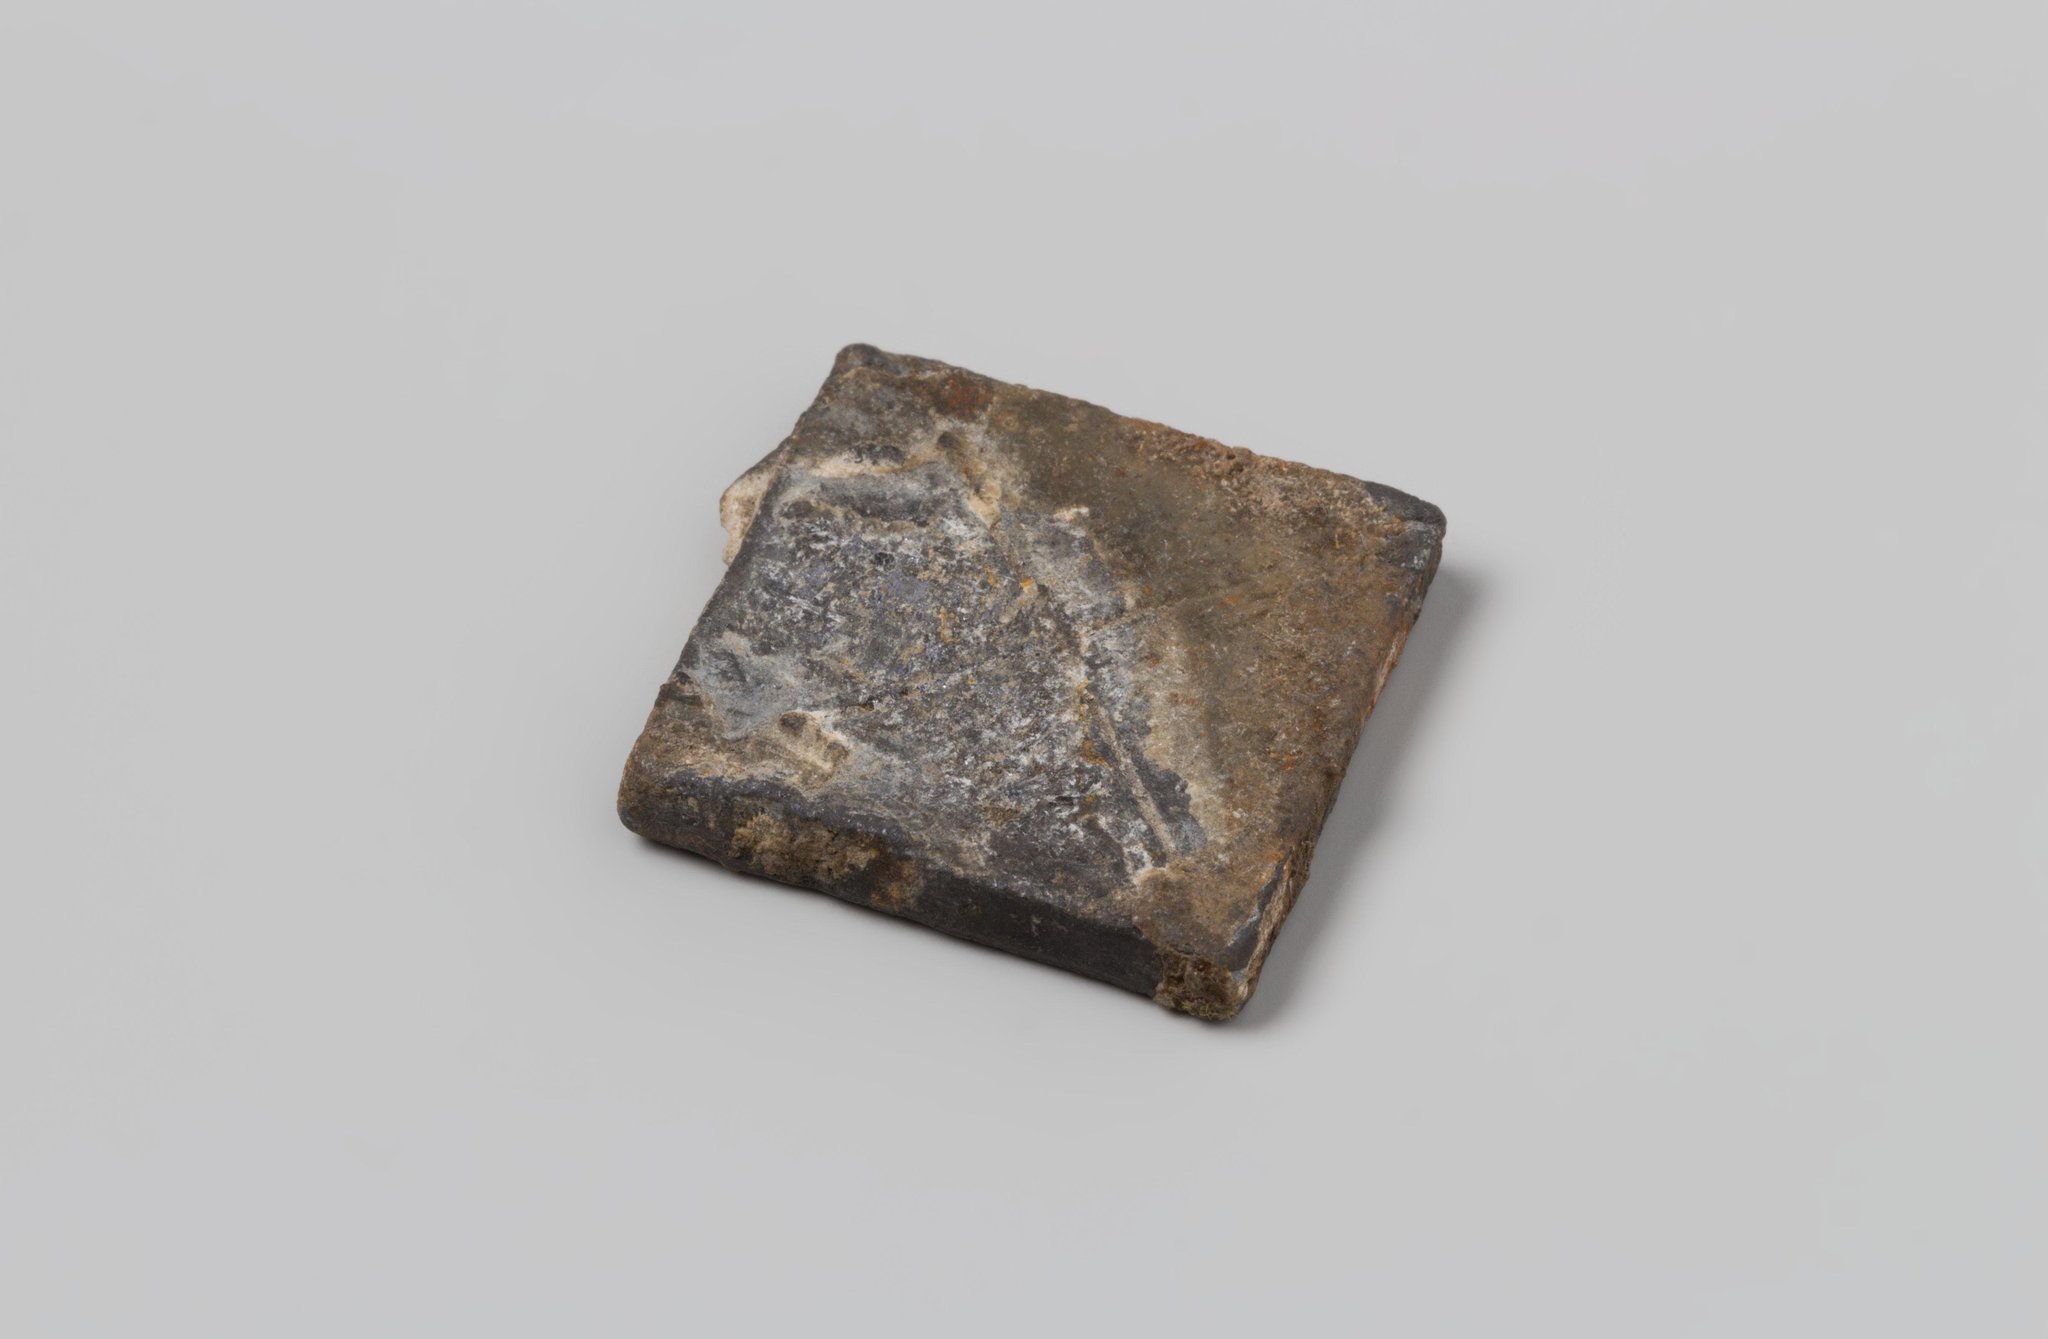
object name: gaming counter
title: Speelpenning uit het wrak van de Oost-Indiëvaarder Hollandia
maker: Anonymous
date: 1700-1743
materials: lead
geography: netherlands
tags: verenigde oostindische compagnie, hollandia (schip), annet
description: Rectangular, square, flat, engraved diagonal cross on one side, game token.